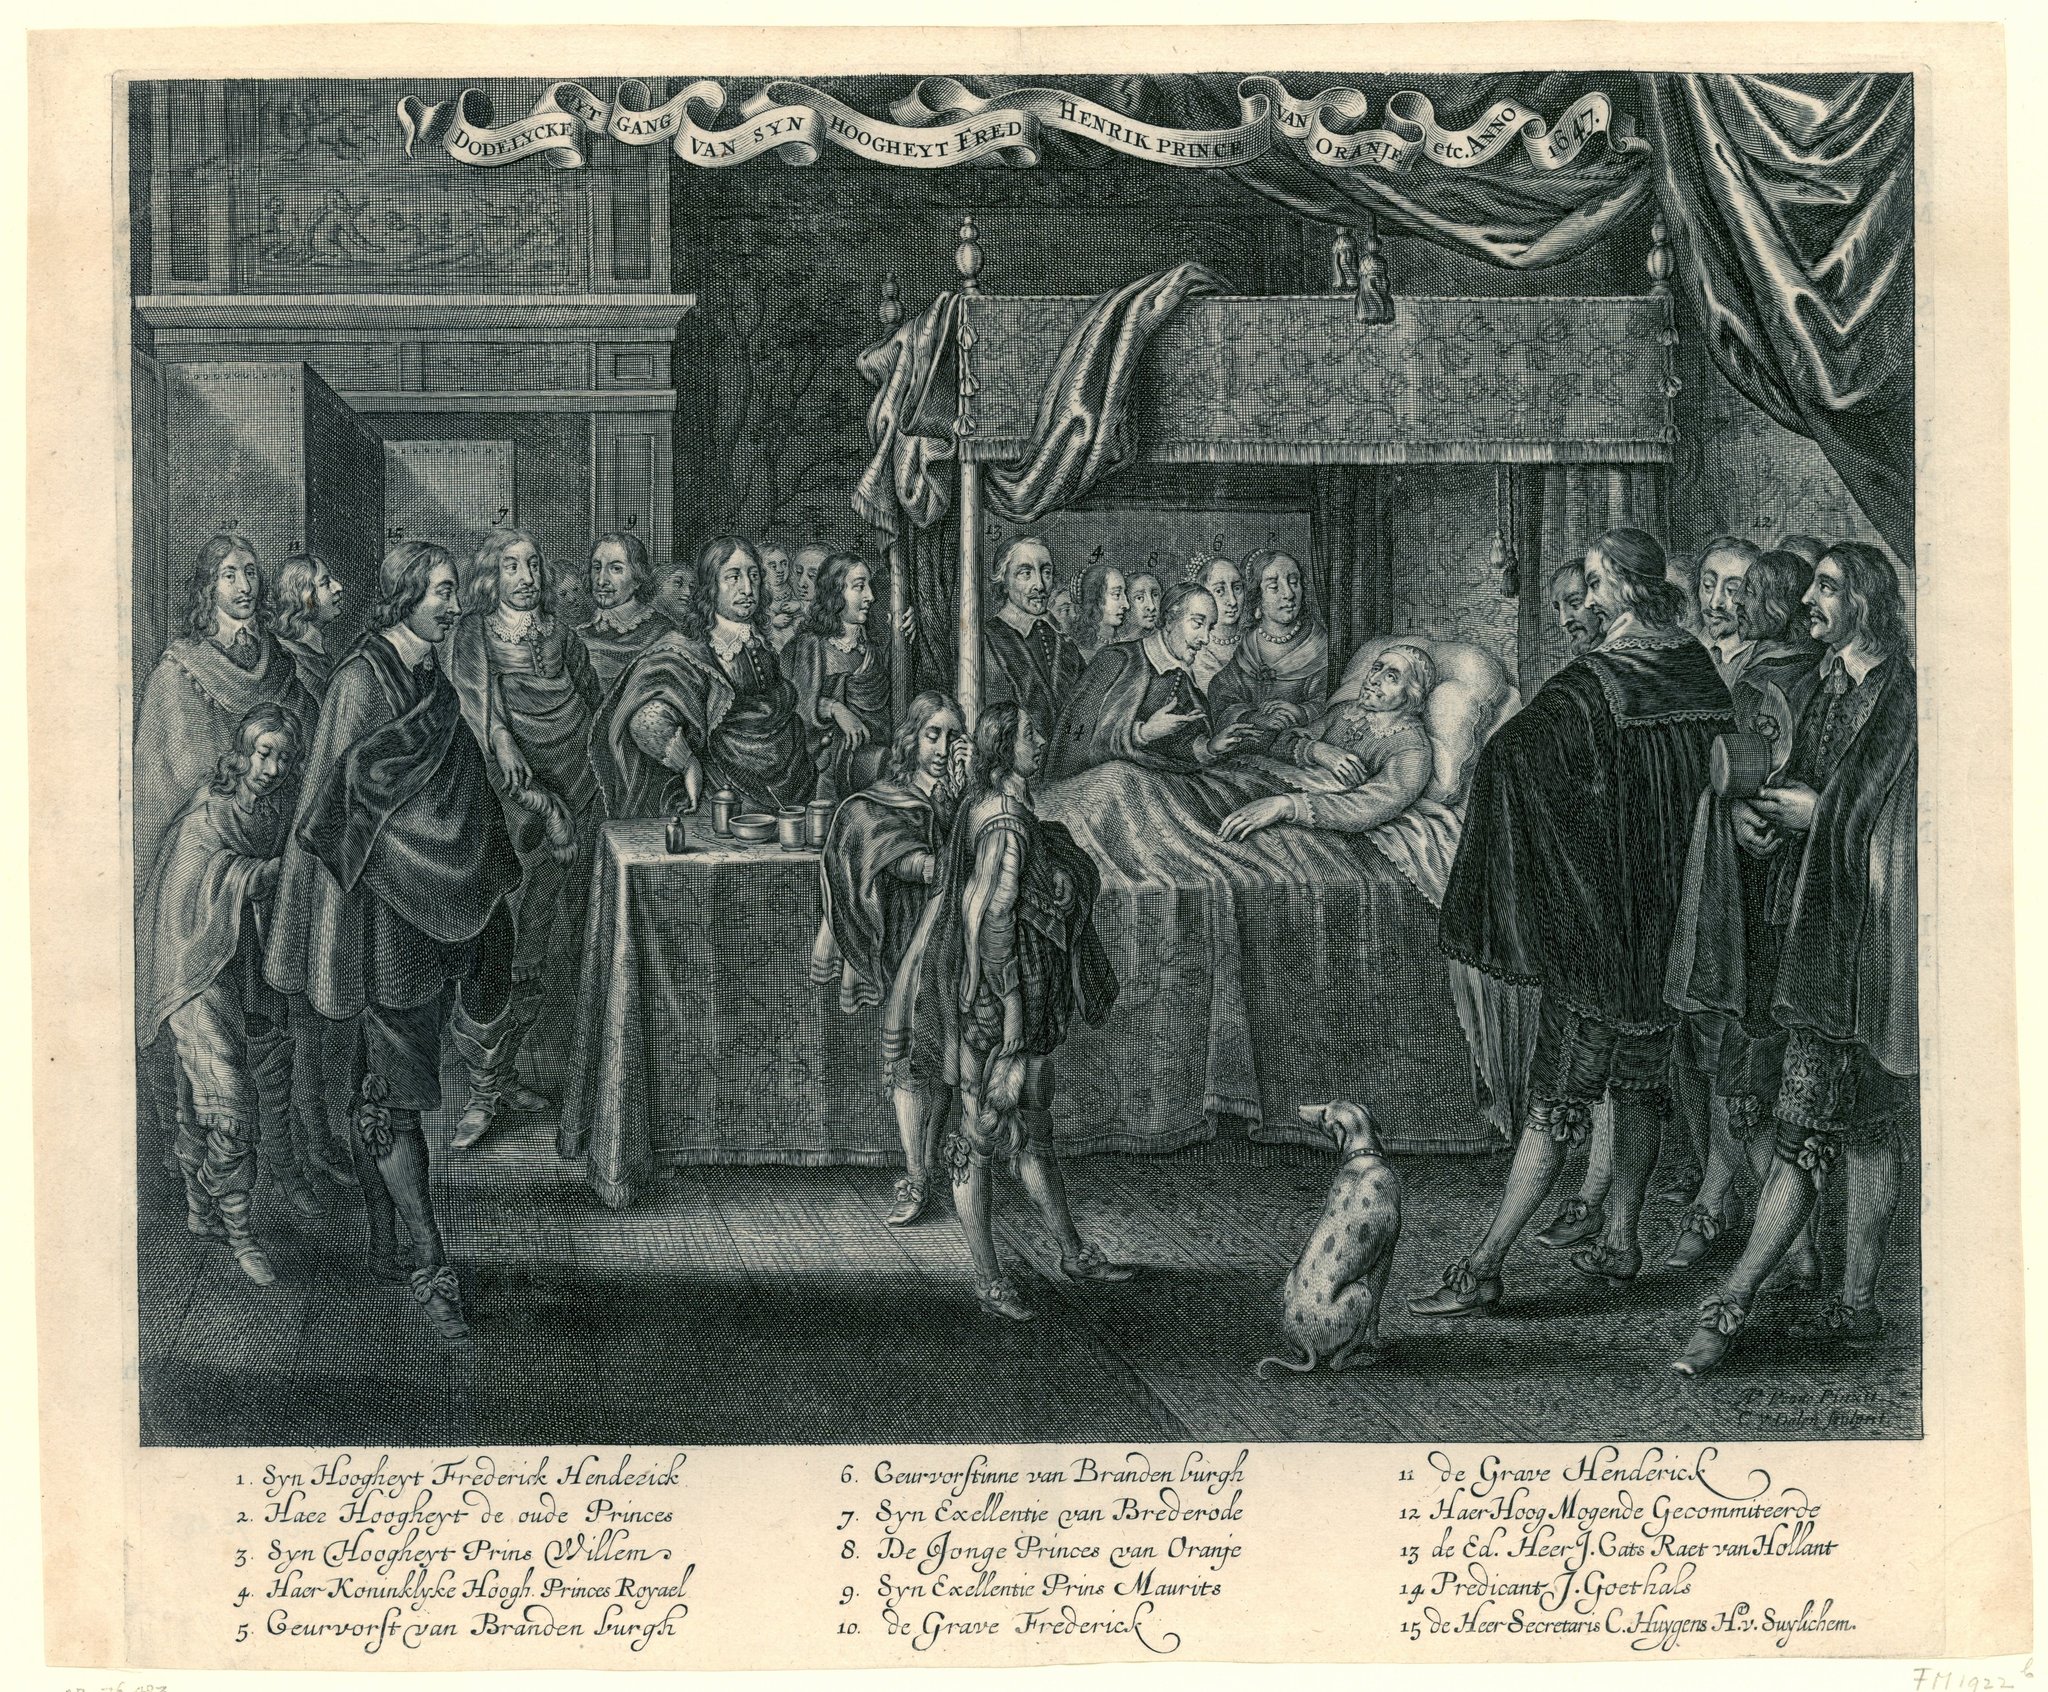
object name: print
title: Sterfbed van Frederik Hendrik, 1647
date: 1647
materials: paper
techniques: engraving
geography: northern netherlands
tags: constantijn huygens (i), johan maurits graaf van nassau-siegen, frederick henry (prince of orange), william ii (prince of orange), amalia of solms-braunfels, frederik willem van brandenburg (i), berlin, louise henriëtte (prinses van oranje), graaf hendrik van nassau-siegen, delft, the hague, jacob cats (1577-1660), london, mary henrietta stuart, maria (prinses van oranje) (1642-1688), deathbed, the death of frederick henry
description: Het sterfbed van Frederik Hendrik. De prins wordt in zijn laatste momenten getroost door de predikant J. Goethals. De directe familieleden van de prins en verschillende bestuurders hebben zich om het bed verzameld. In de voorstelling worden zij met cijfers aangeduid. In de legenda 1-15 onder de voorstelling staan de corresponderende namen. Dit exemplaar heeft op de achterkant een gedicht van Cats over twee kolommen. De prent is volgens deze tekst gebruikt als inleiding bij het gedicht 'de Doot-kiste voor de levenden' (1647).